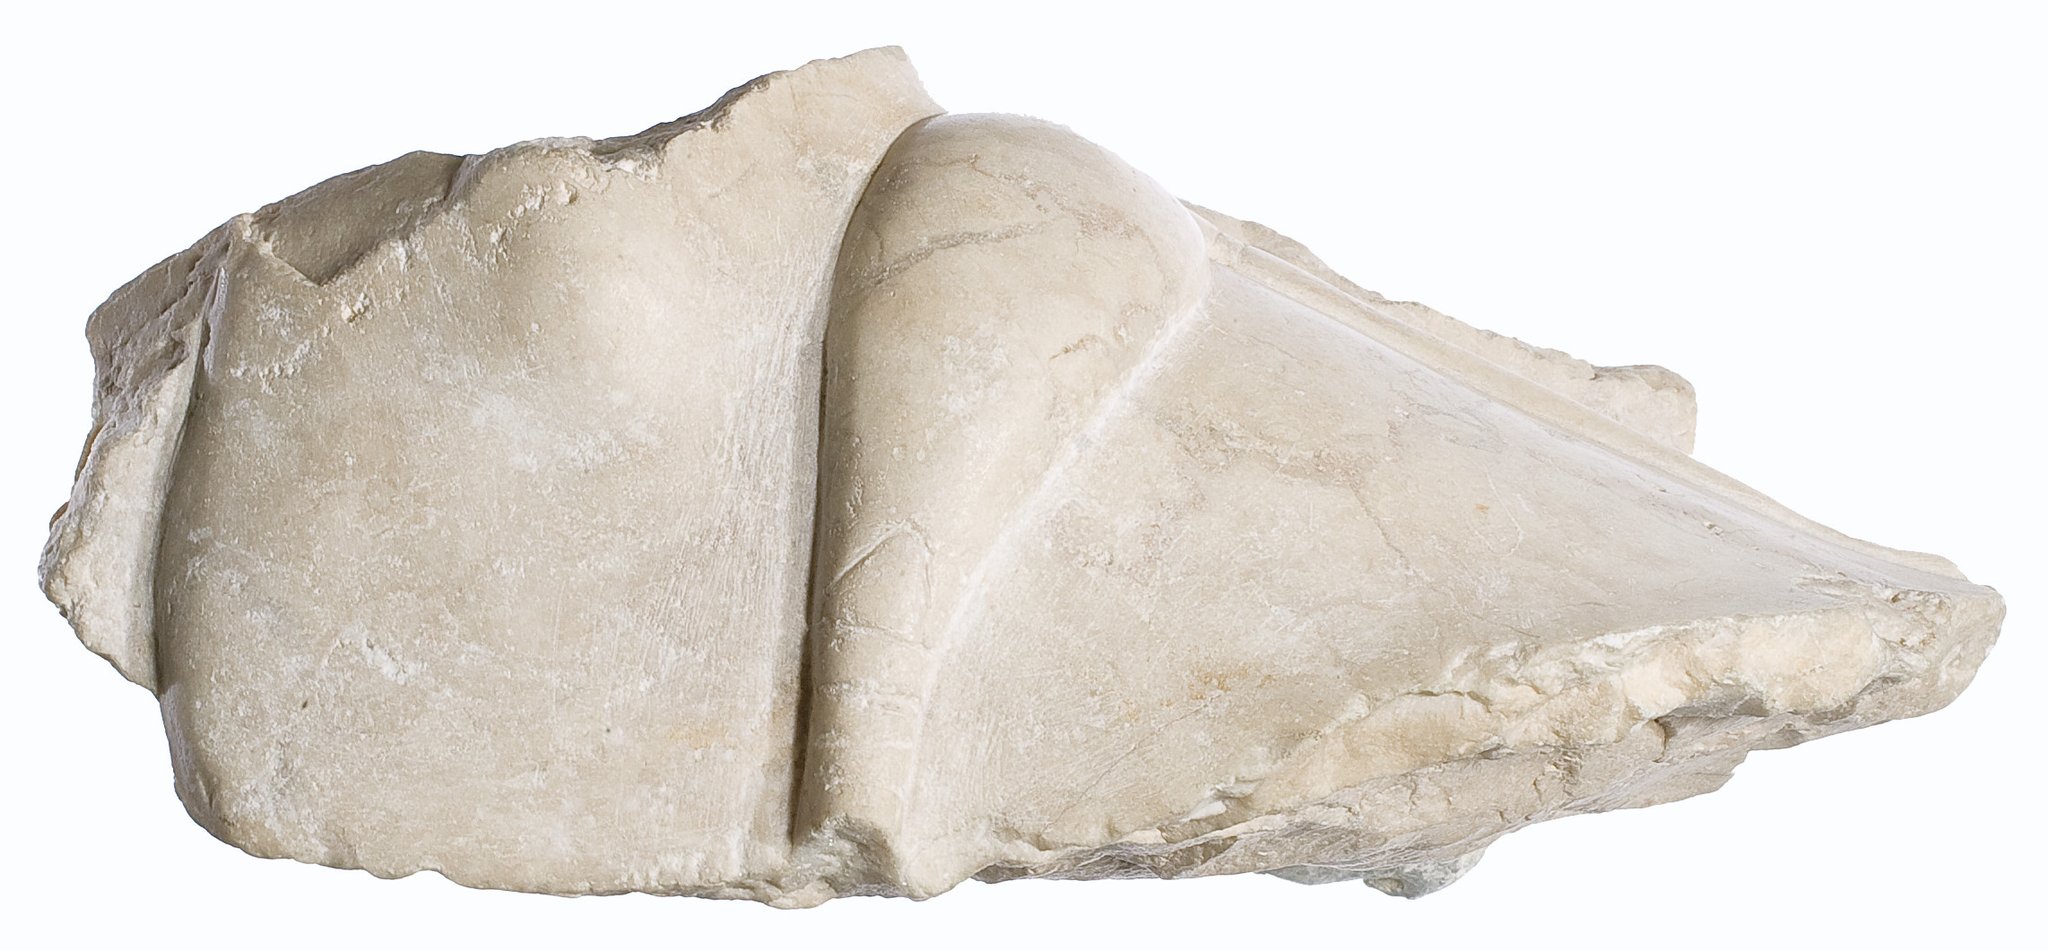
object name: foot fragment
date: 1353-1336 BCE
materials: limestone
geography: egypt